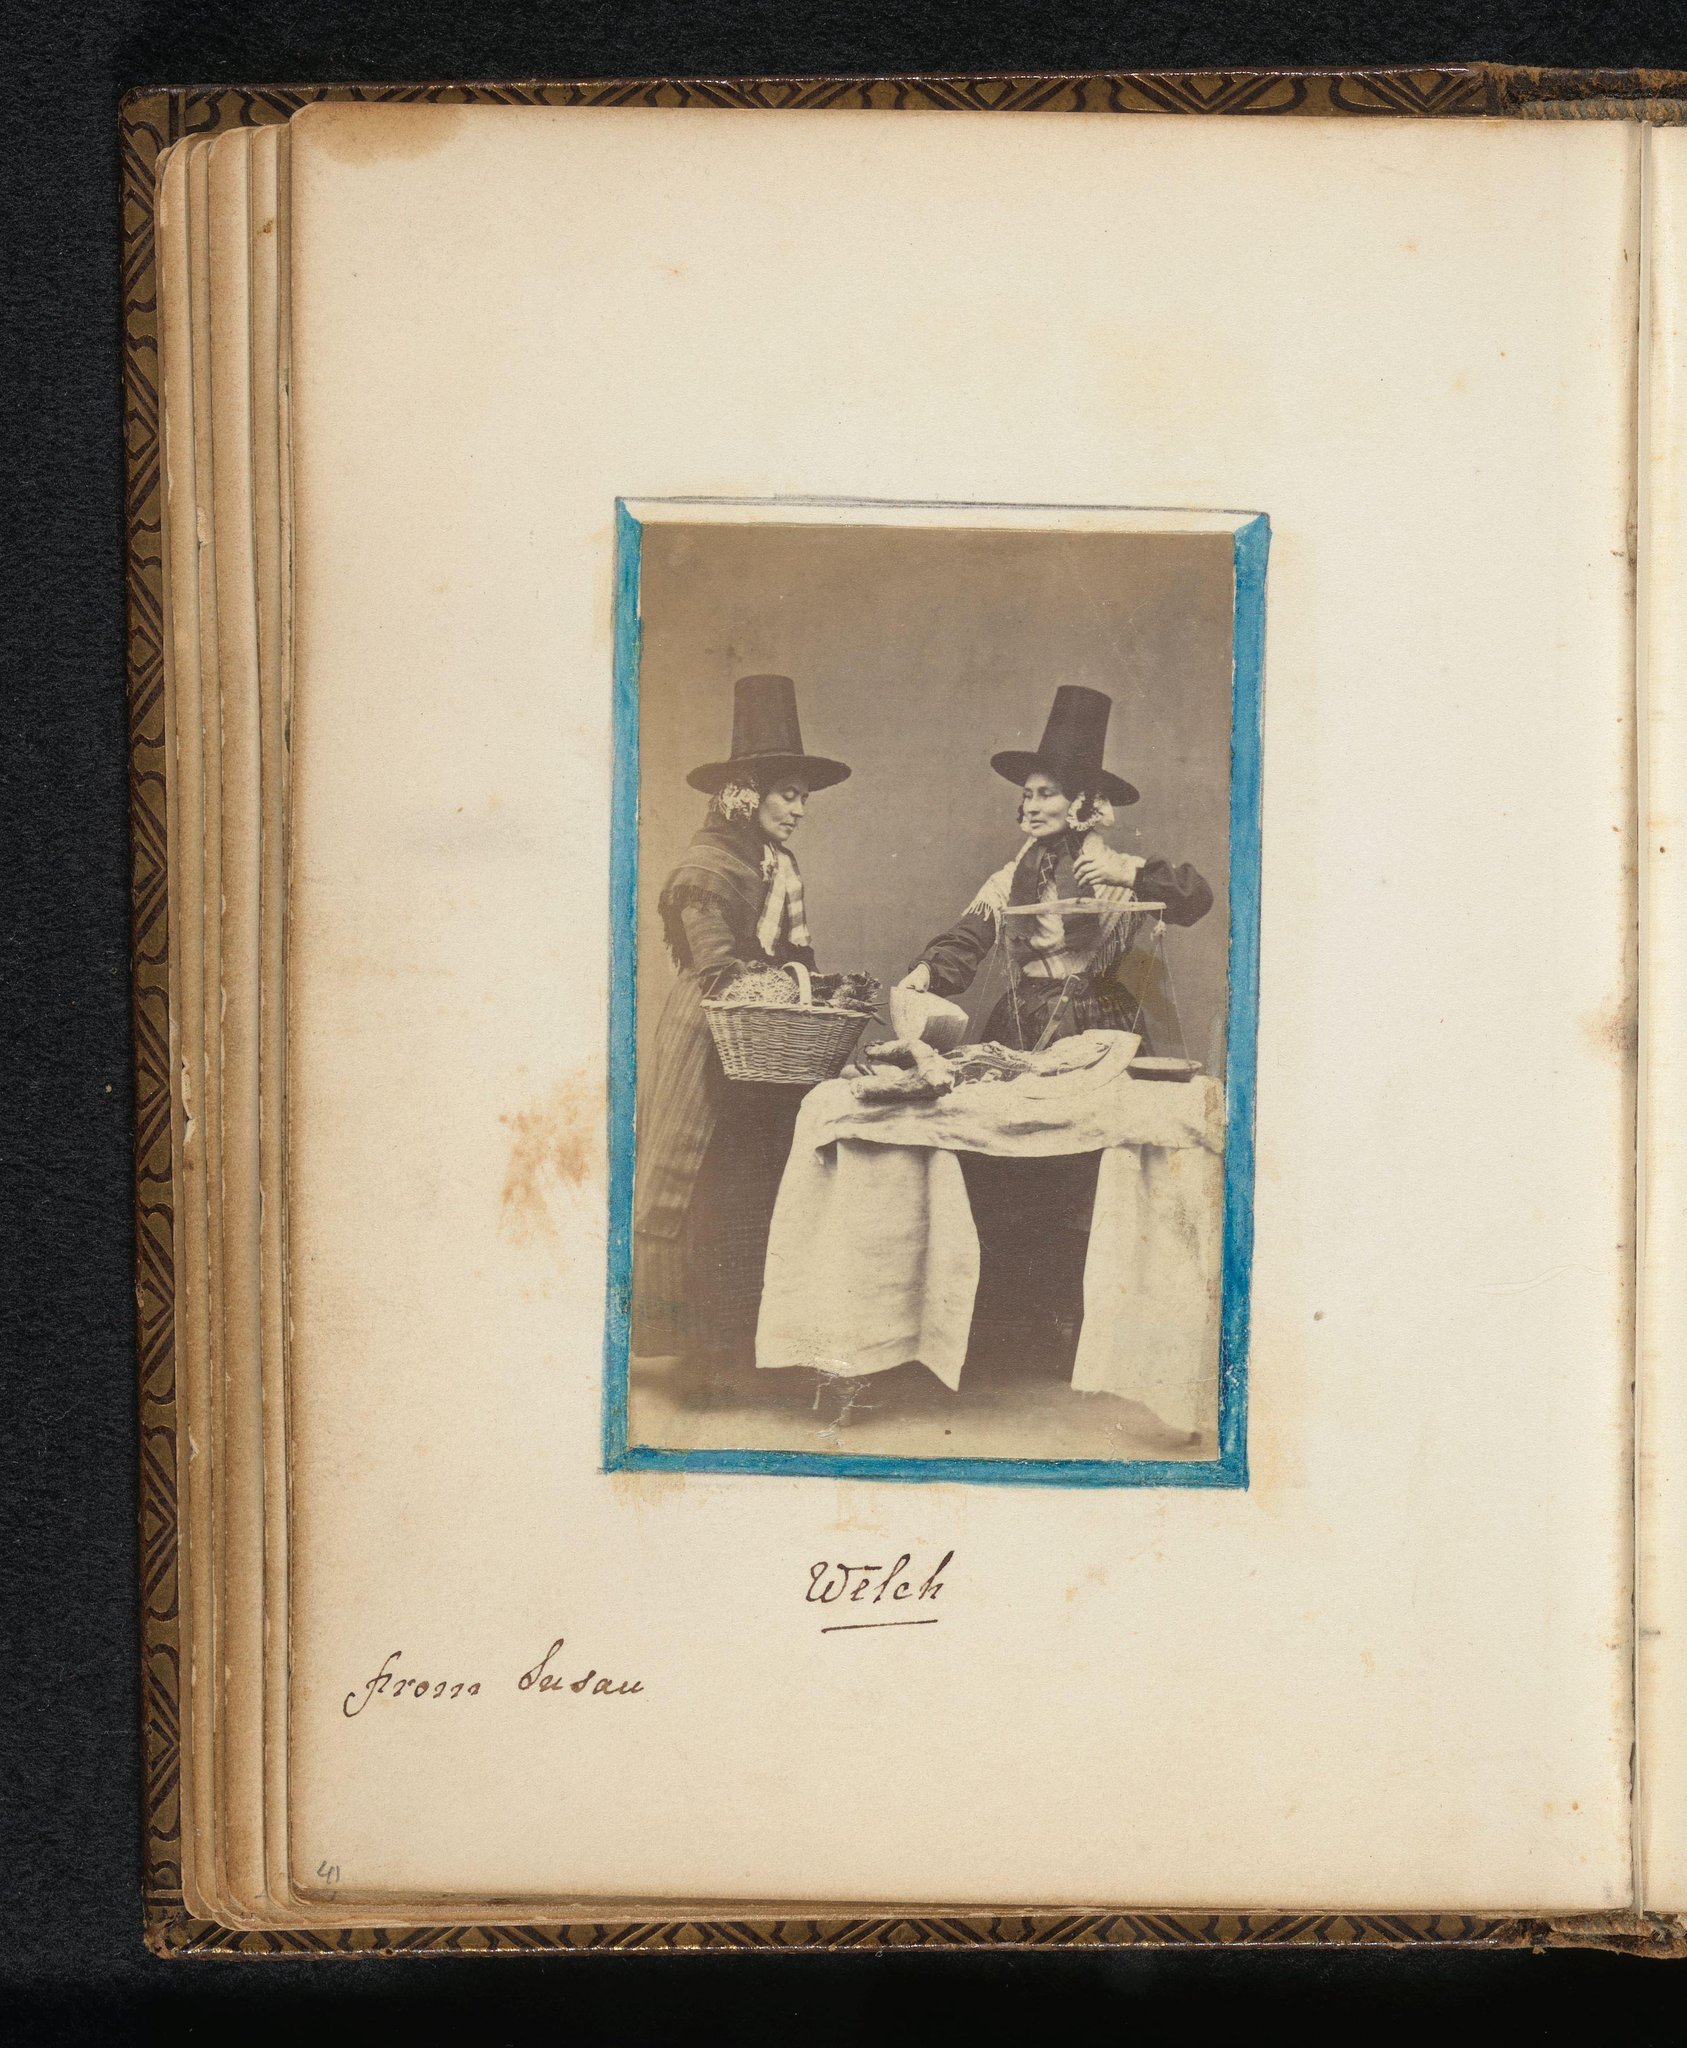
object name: album leaf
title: Vrouwen in klederdracht uit Wales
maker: Anonymous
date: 1865-1867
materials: cardboard, photographic support, watercolor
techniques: albumen print, aquarelle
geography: england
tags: folk costume, regional costume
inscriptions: annotation: ‘Welch / from Susan’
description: Twee vrouwen in klederdracht uit Wales bij een stalletje met kaas. Foto op albumblad in album met 68 foto's merendeels met geaquarelleerde randversieringen. Het zijn voornamelijk portretten op carte-de-visite formaat.